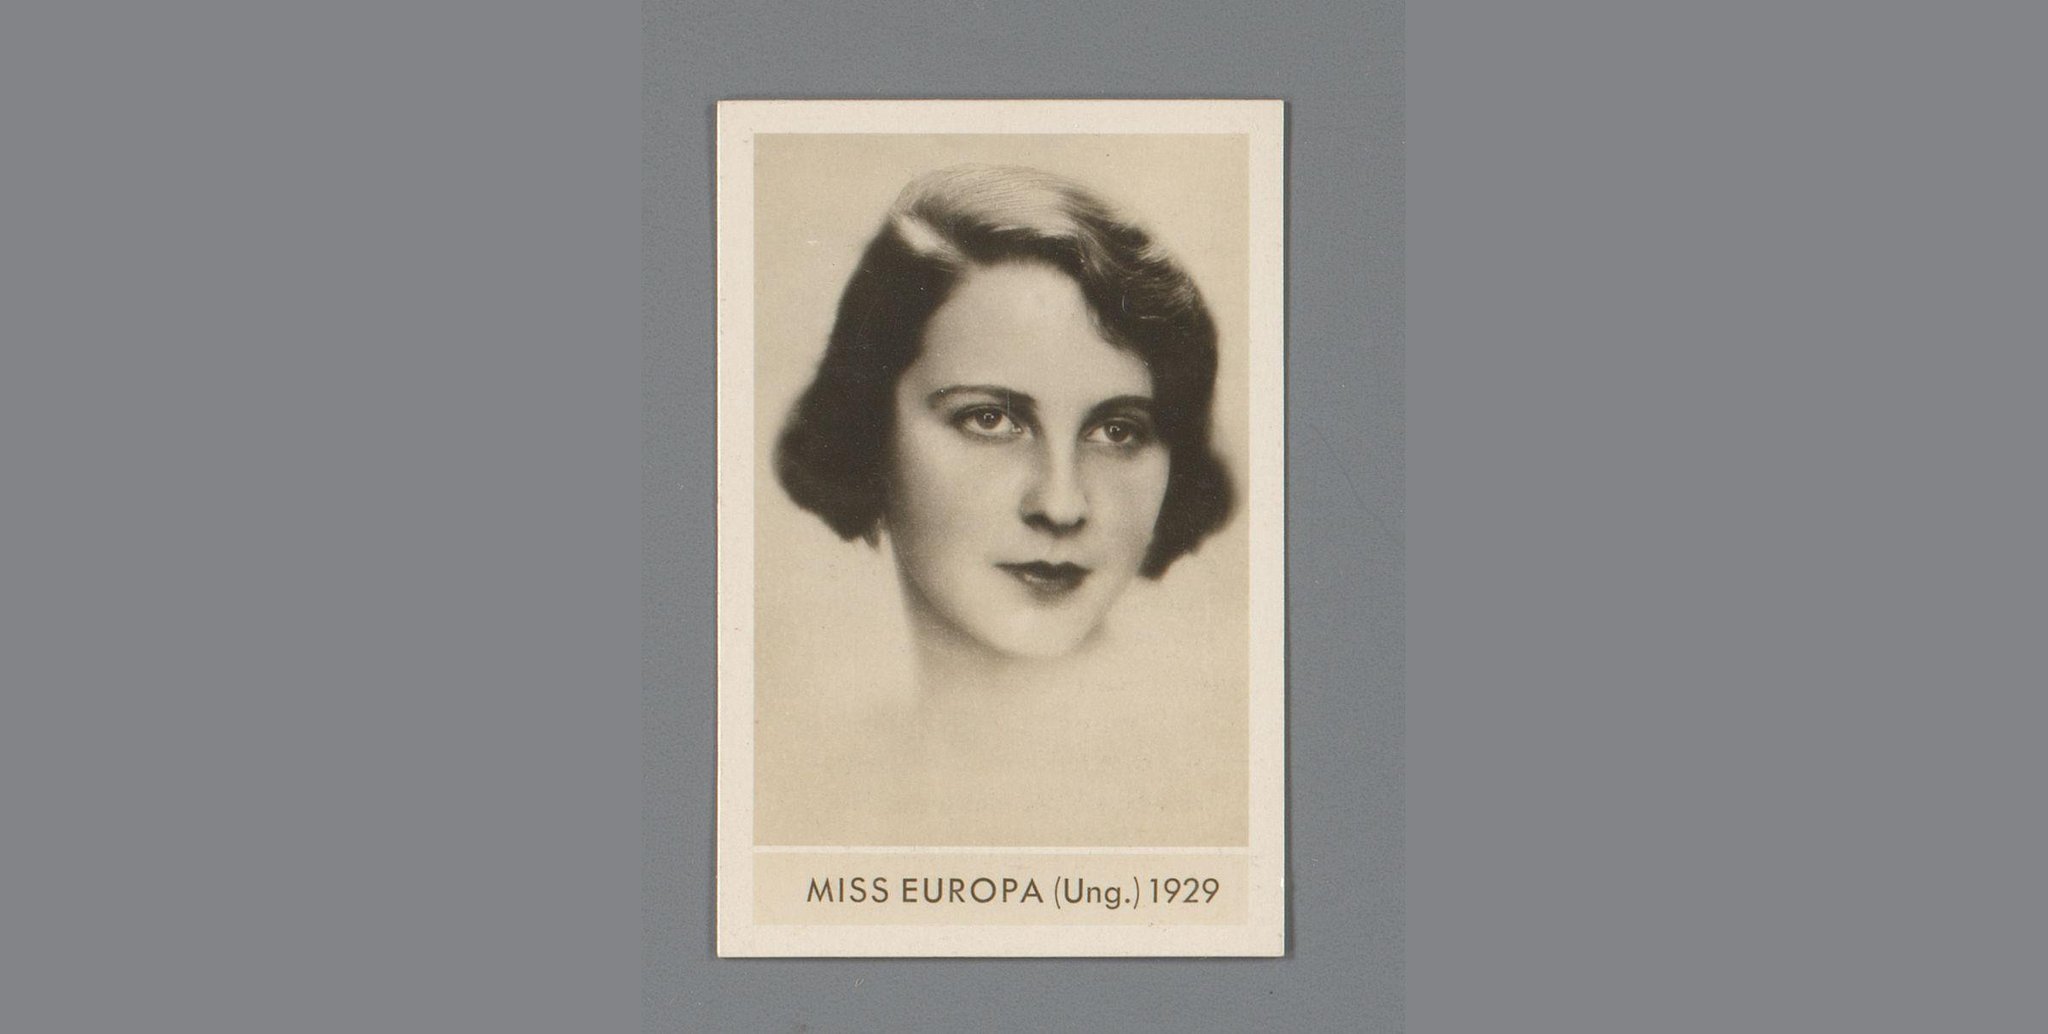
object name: photograph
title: Miss Europa (Ung.) 1929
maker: Anonymous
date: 1929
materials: paper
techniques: gelatin silver print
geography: dresden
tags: historical persons - bb - woman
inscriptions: inscription: ‘Die schönsten/ Frauen der Welt/ dargestellt durch die Schön-/ heitsköniginnen aller Länder,/ finden Sie in 190 echten/ Bromsilber-Fotos, die nur den/ CLUB-und-LIGA-Packun-/ gen beiliegen. Eind prächtiges/ Sammel-Album erhalten Sie/ für 75 Pfennig vom Händler/ oder bei Einsendung von/ 75 Pfennig in Briefmarken/ von der Bilderstelle Lohse,/ Dresden A24, Nossener Str. 1./ Ges. gesch. Nachdruck verboten!’